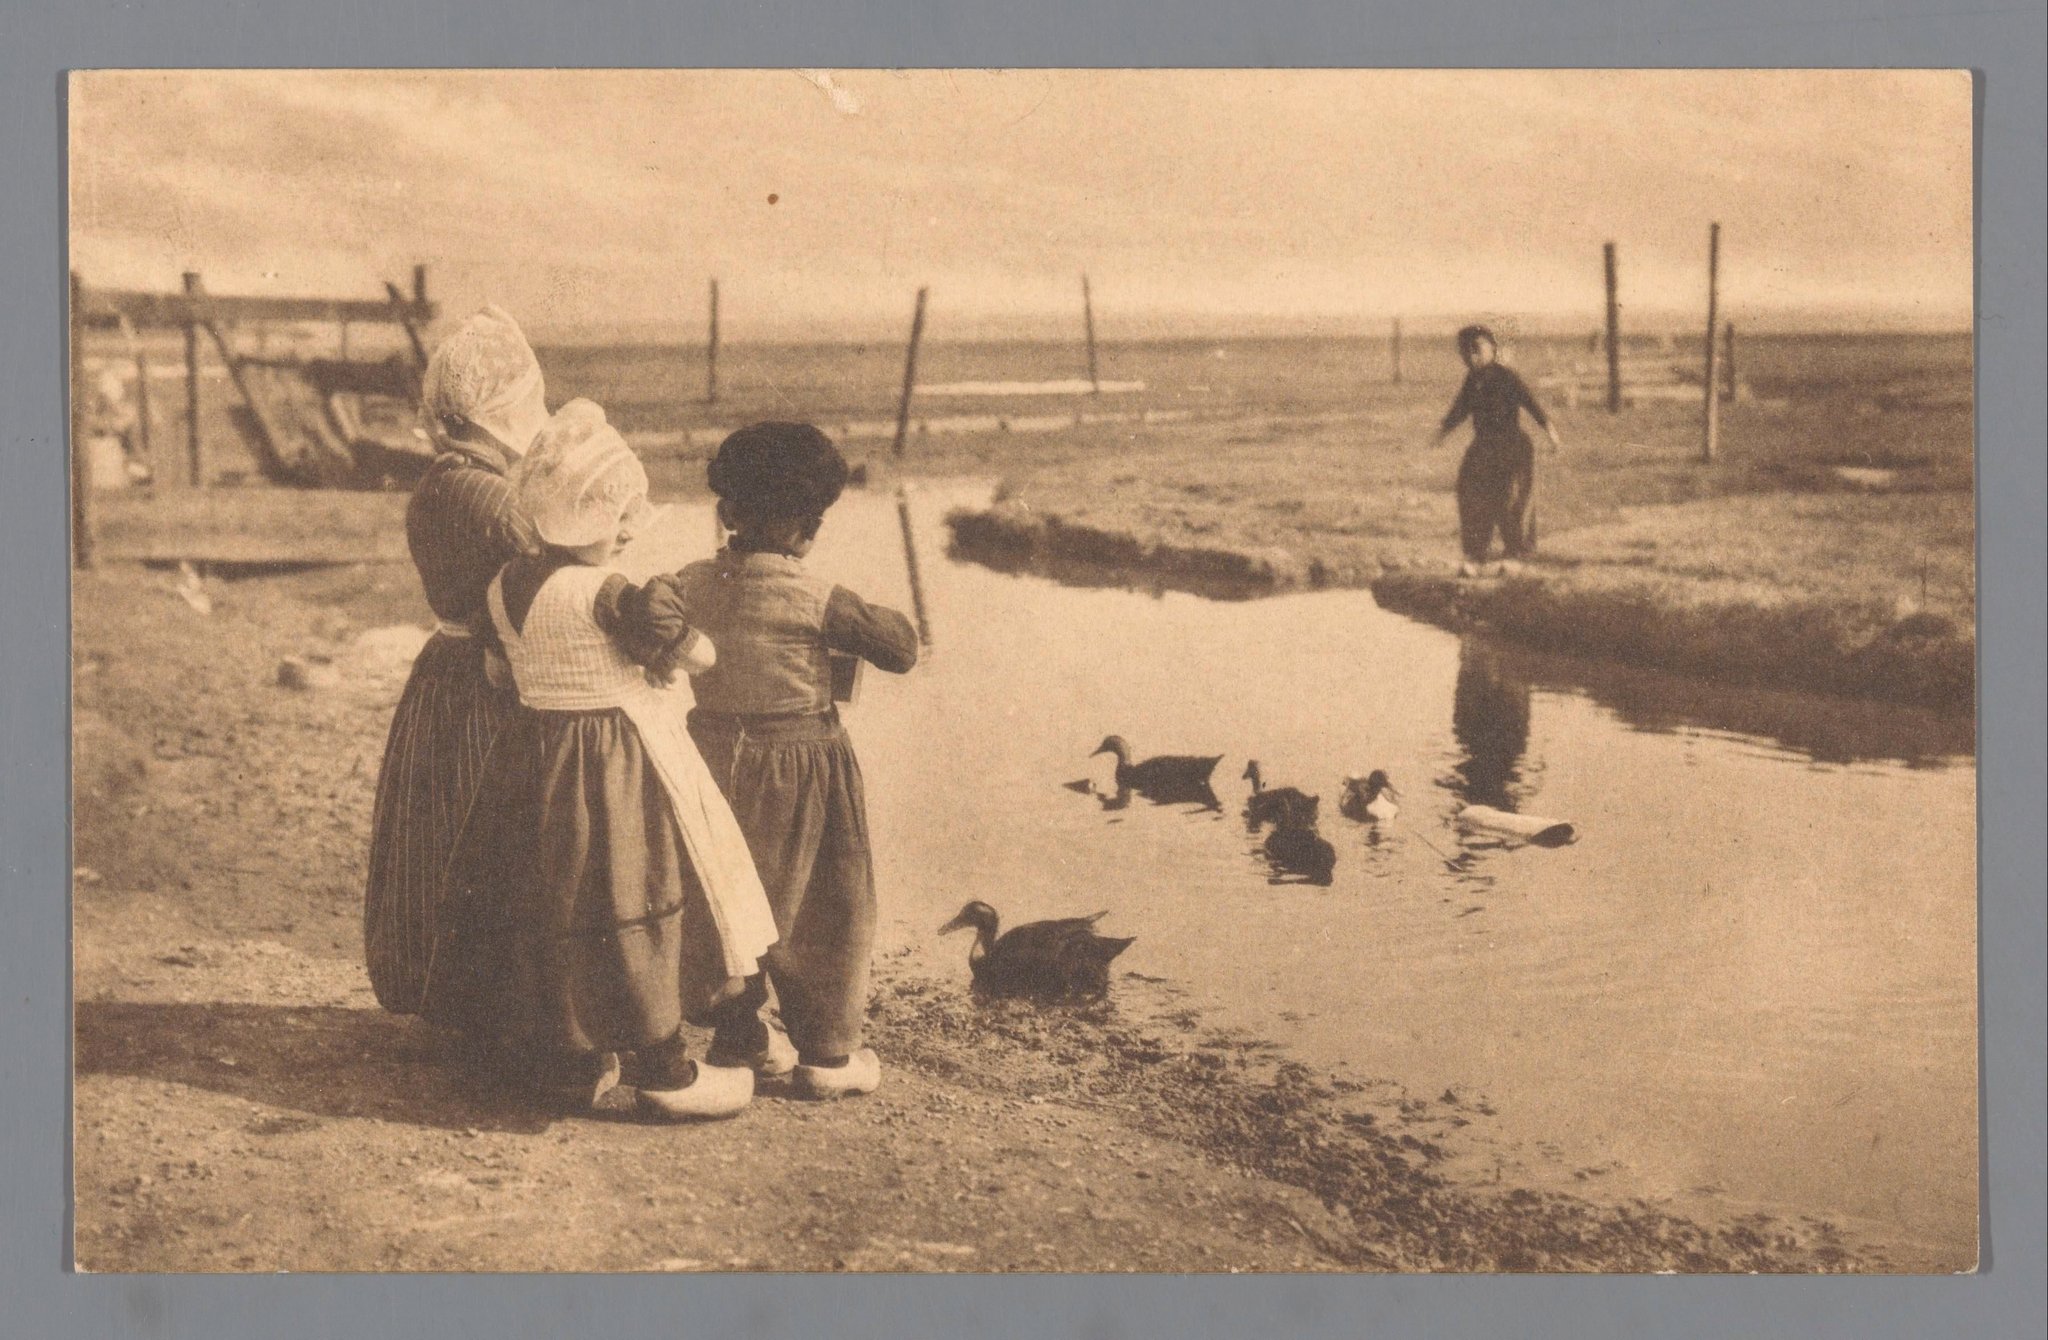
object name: ansichtkaart, prentbriefkaart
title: Eendjes voeren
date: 1890-1920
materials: cardboard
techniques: photograph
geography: volendam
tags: child, landscapes with waters, waterscapes, seascapes (in the temperate zone), folk costume, regional costume